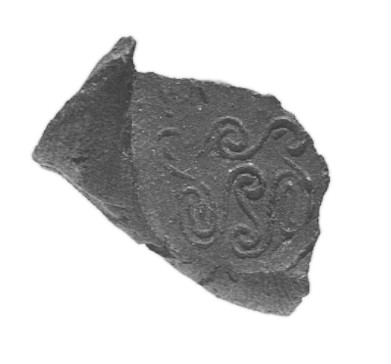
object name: sealing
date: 2030-1640 BCE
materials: clay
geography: egypt